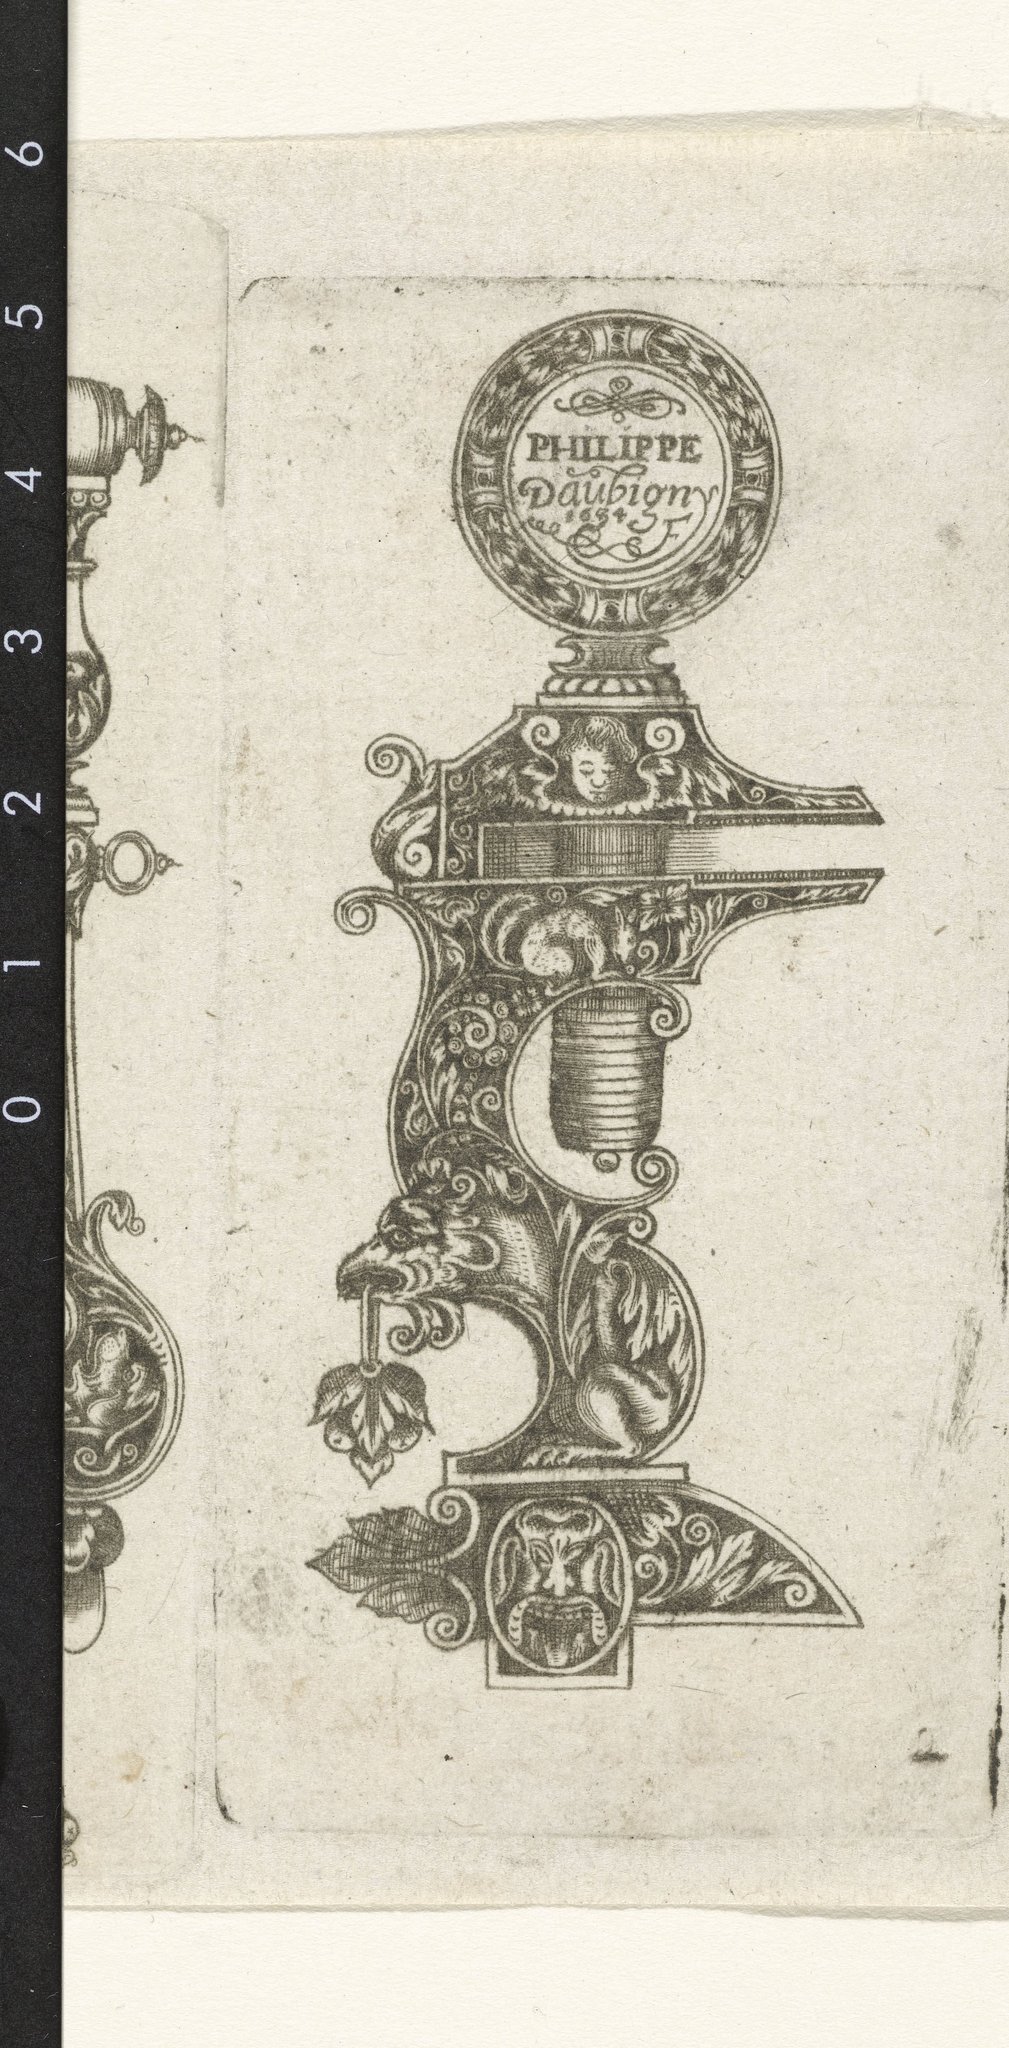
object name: print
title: Haan van vuursteengeweer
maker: philippe cordier daubigny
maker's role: print maker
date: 1634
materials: paper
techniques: etching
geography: paris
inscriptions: date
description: Gedecoreerd met een cherubijn, een konijn, een hond en een masker. Blad 2 uit een serie van 14.